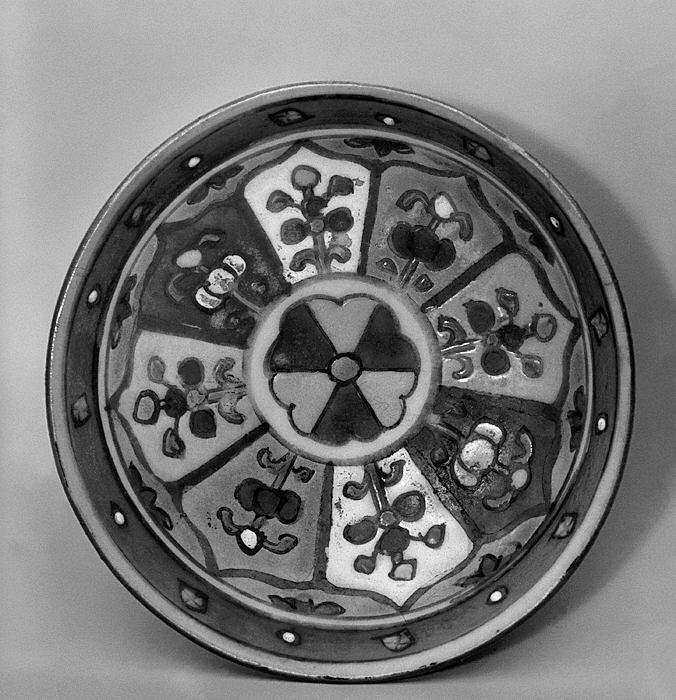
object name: saucer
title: Saucer with floral pattern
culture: chinese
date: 1801-1900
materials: enamel, porcelain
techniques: overglaze, painting, polychrome